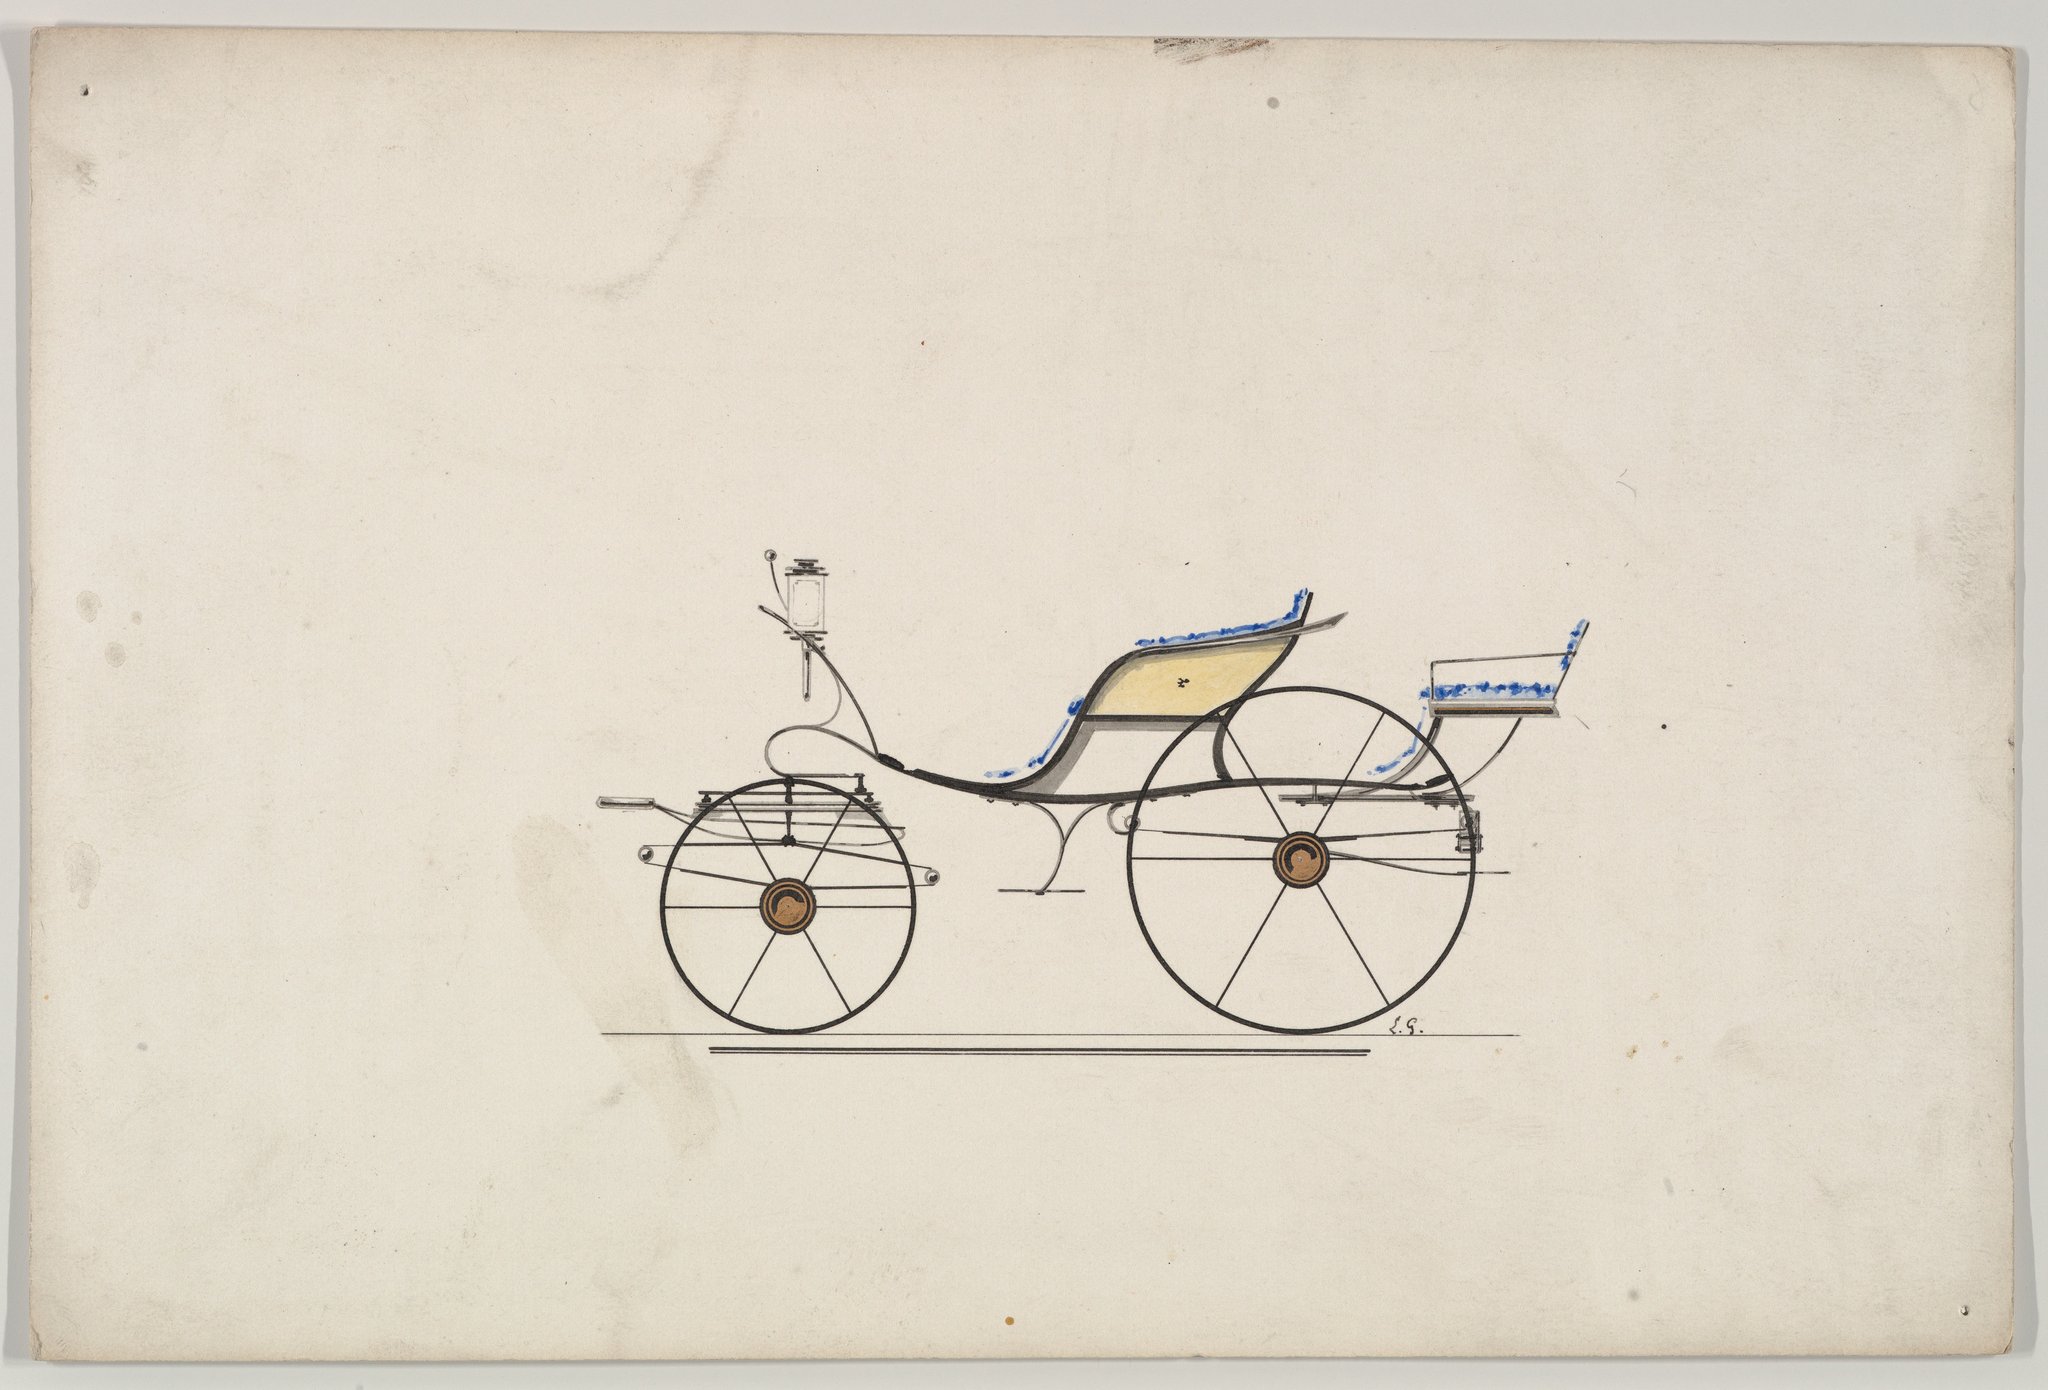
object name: drawing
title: George IV Phaeton (unnumbered)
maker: brewster & co.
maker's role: manufacturer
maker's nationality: american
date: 1870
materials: gouache, ink, watercolor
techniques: pen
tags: carriages